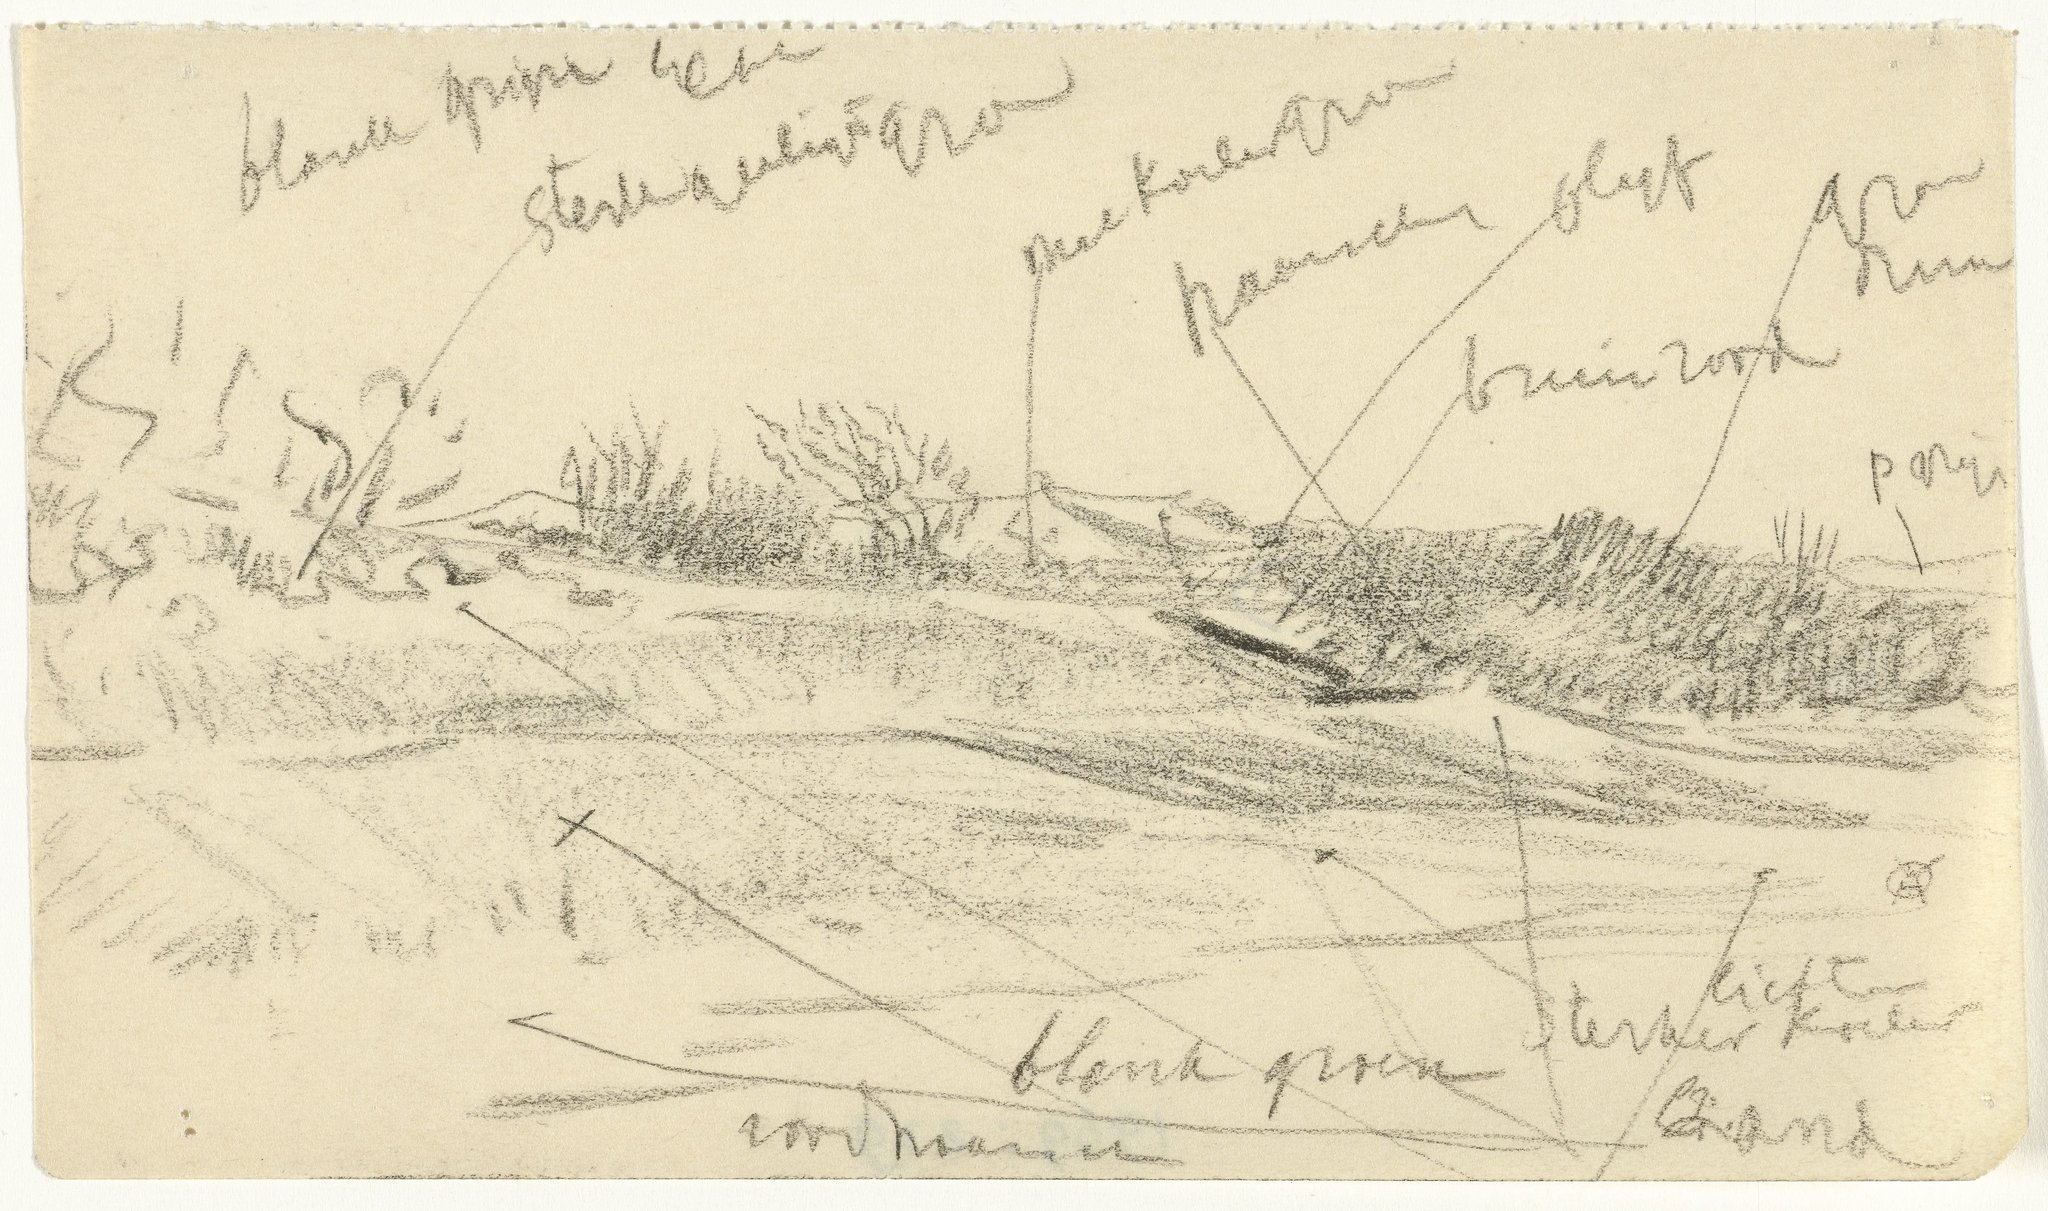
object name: drawing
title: Landschap aan de voet van een heuvel, met kleurnotities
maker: gerrit willem dijsselhof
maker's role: designer, draughtsman, print maker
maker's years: 1866-1924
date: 1876-1924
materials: chalk, paper